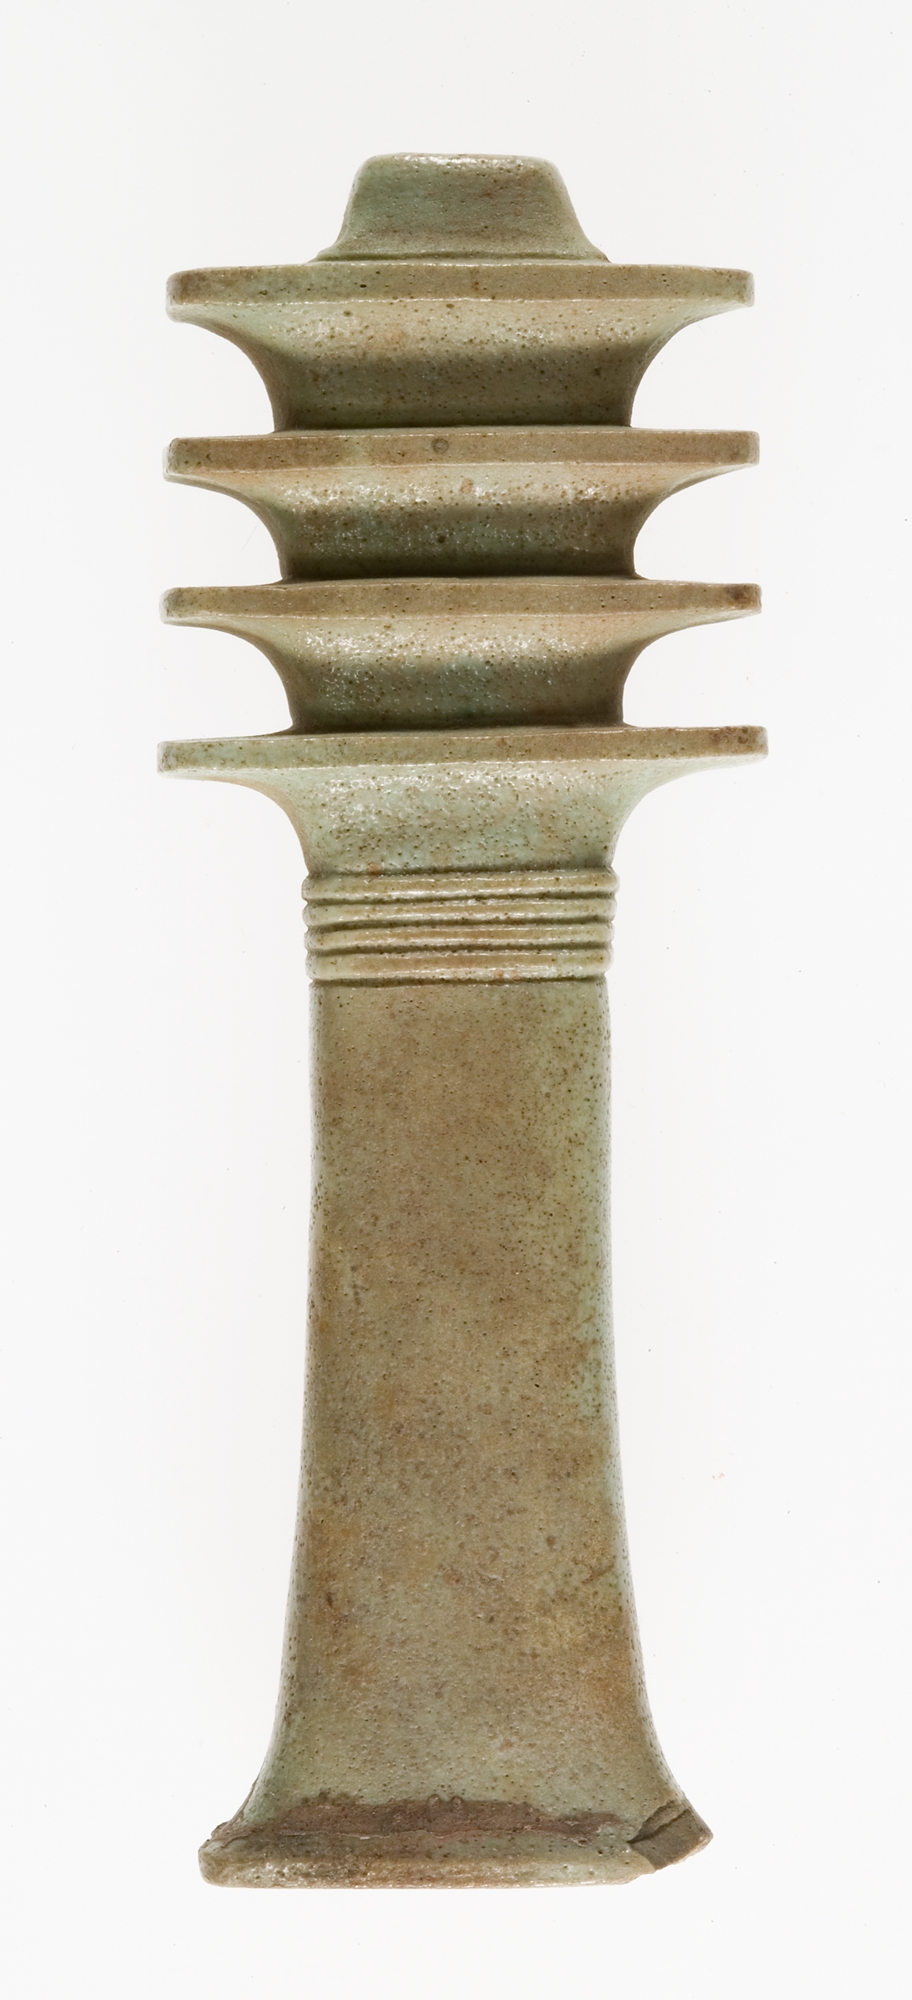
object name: amulet, djed pillar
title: Djed Pillar Amulet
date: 664-332 BCE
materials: faience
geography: egypt